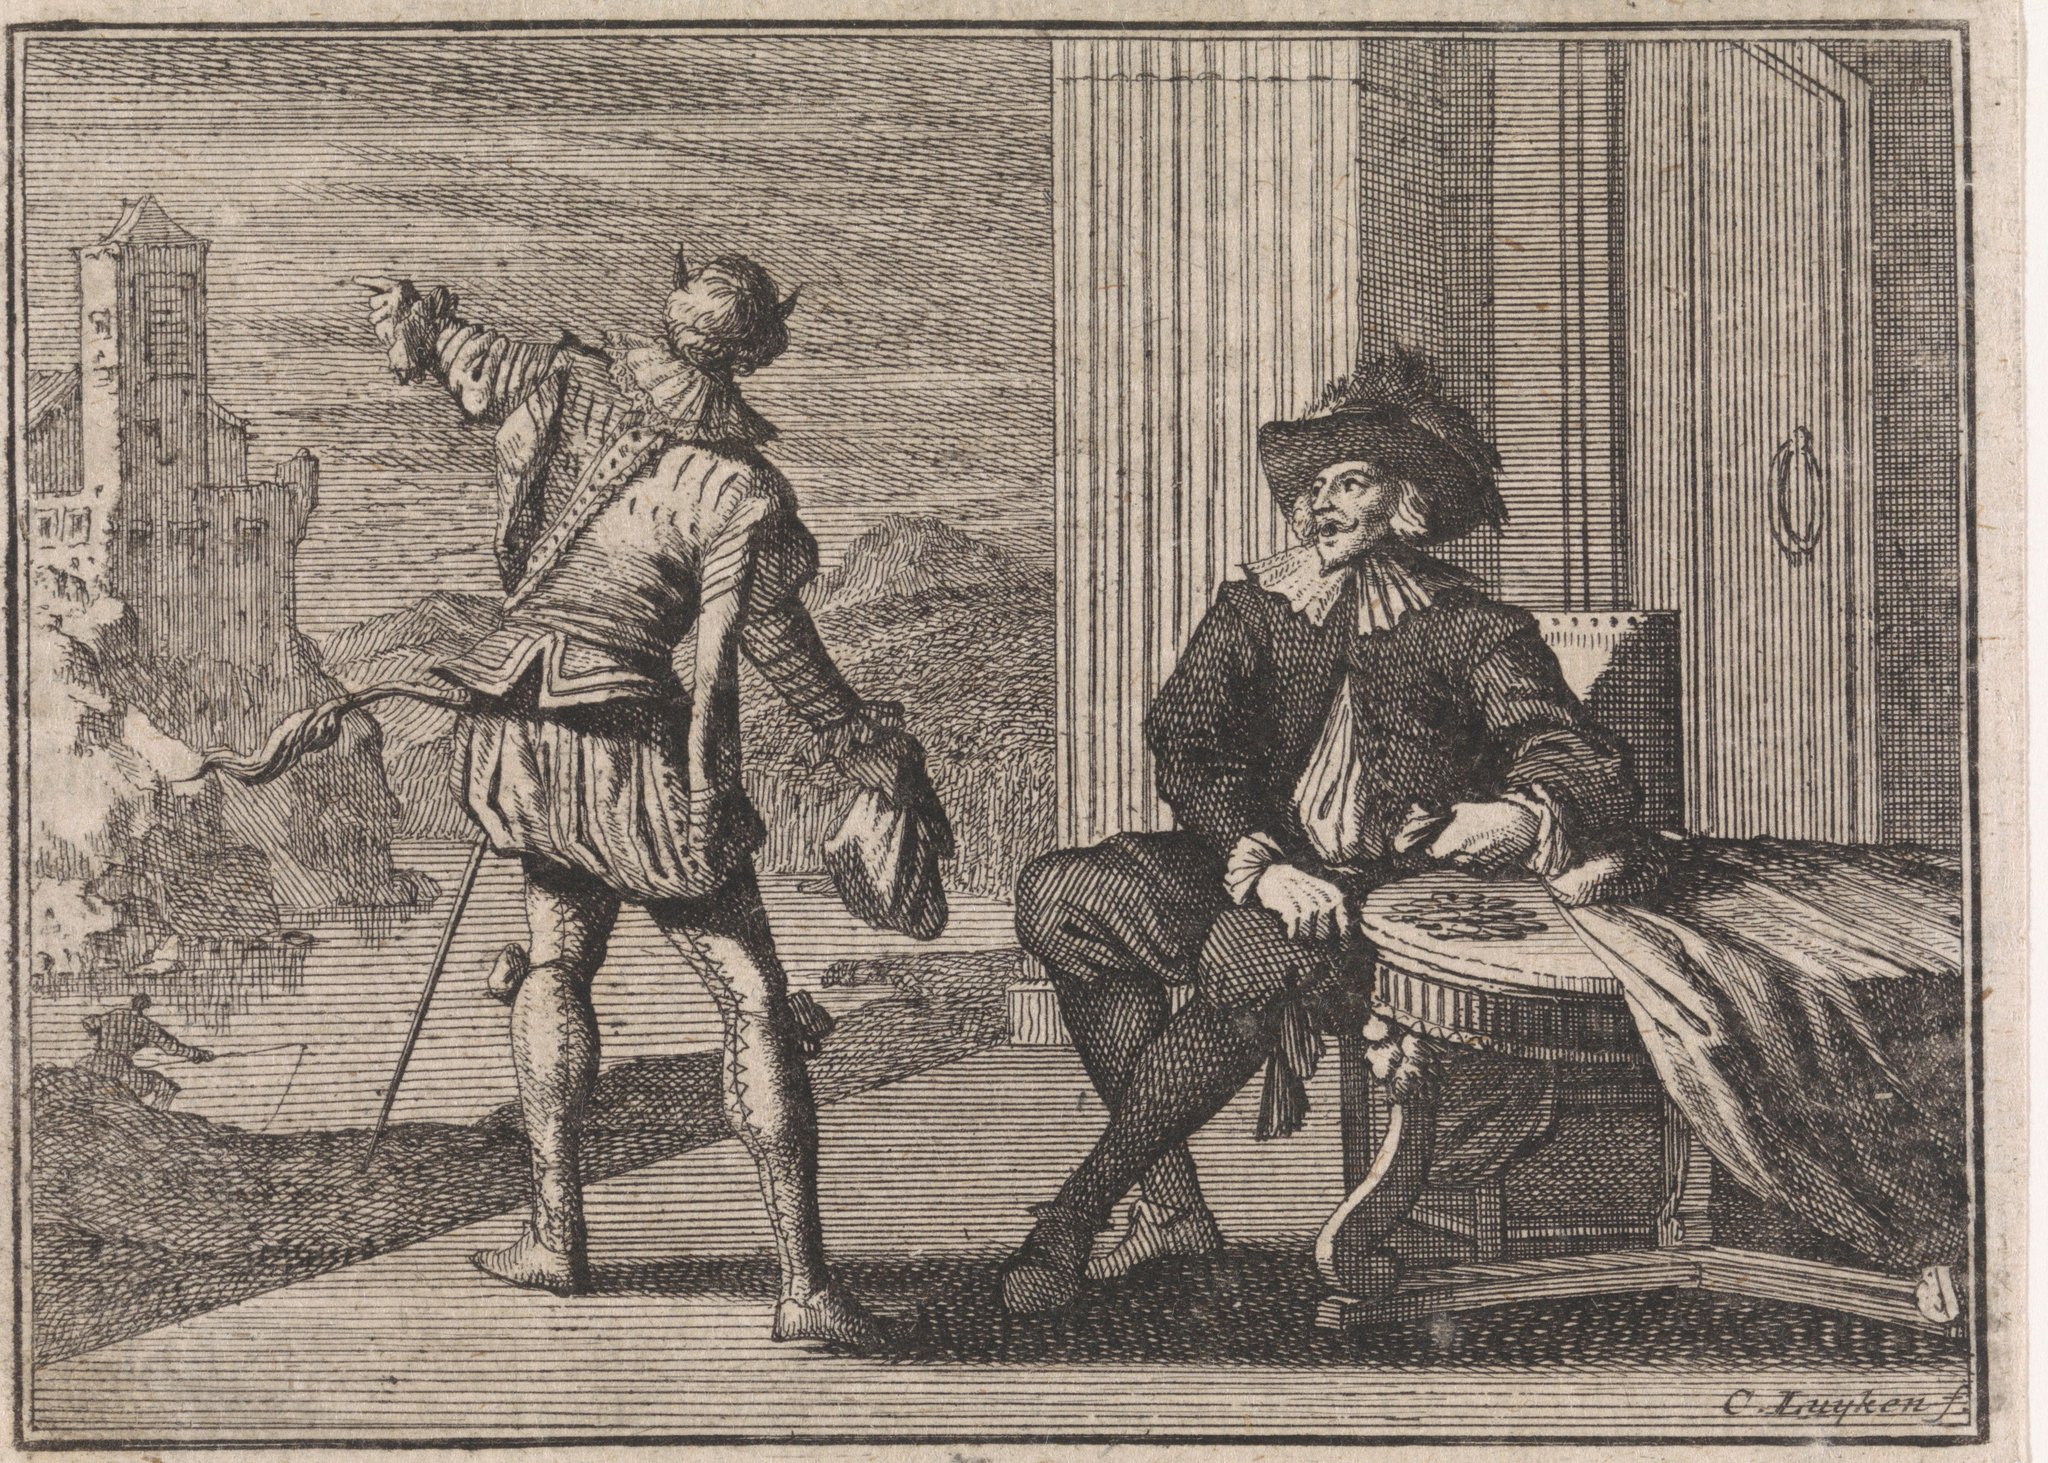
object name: print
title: Duivel stelt aan een gierige edelman voor om zijn kasteel te verkopen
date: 1710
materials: paper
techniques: etching, letterpress printing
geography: nuremberg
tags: devil(s) and demons, landscape with tower or castle, miser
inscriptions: collector's mark: Lugt 2228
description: Illustratie uit: Abraham a Sancta Clara. Heilsames Gemisch Gemasch, das ist: Allerley seltsame und verwunderliche Geschichten (...). Neurenberg: Christoph Weigel, 1710, p. 511.